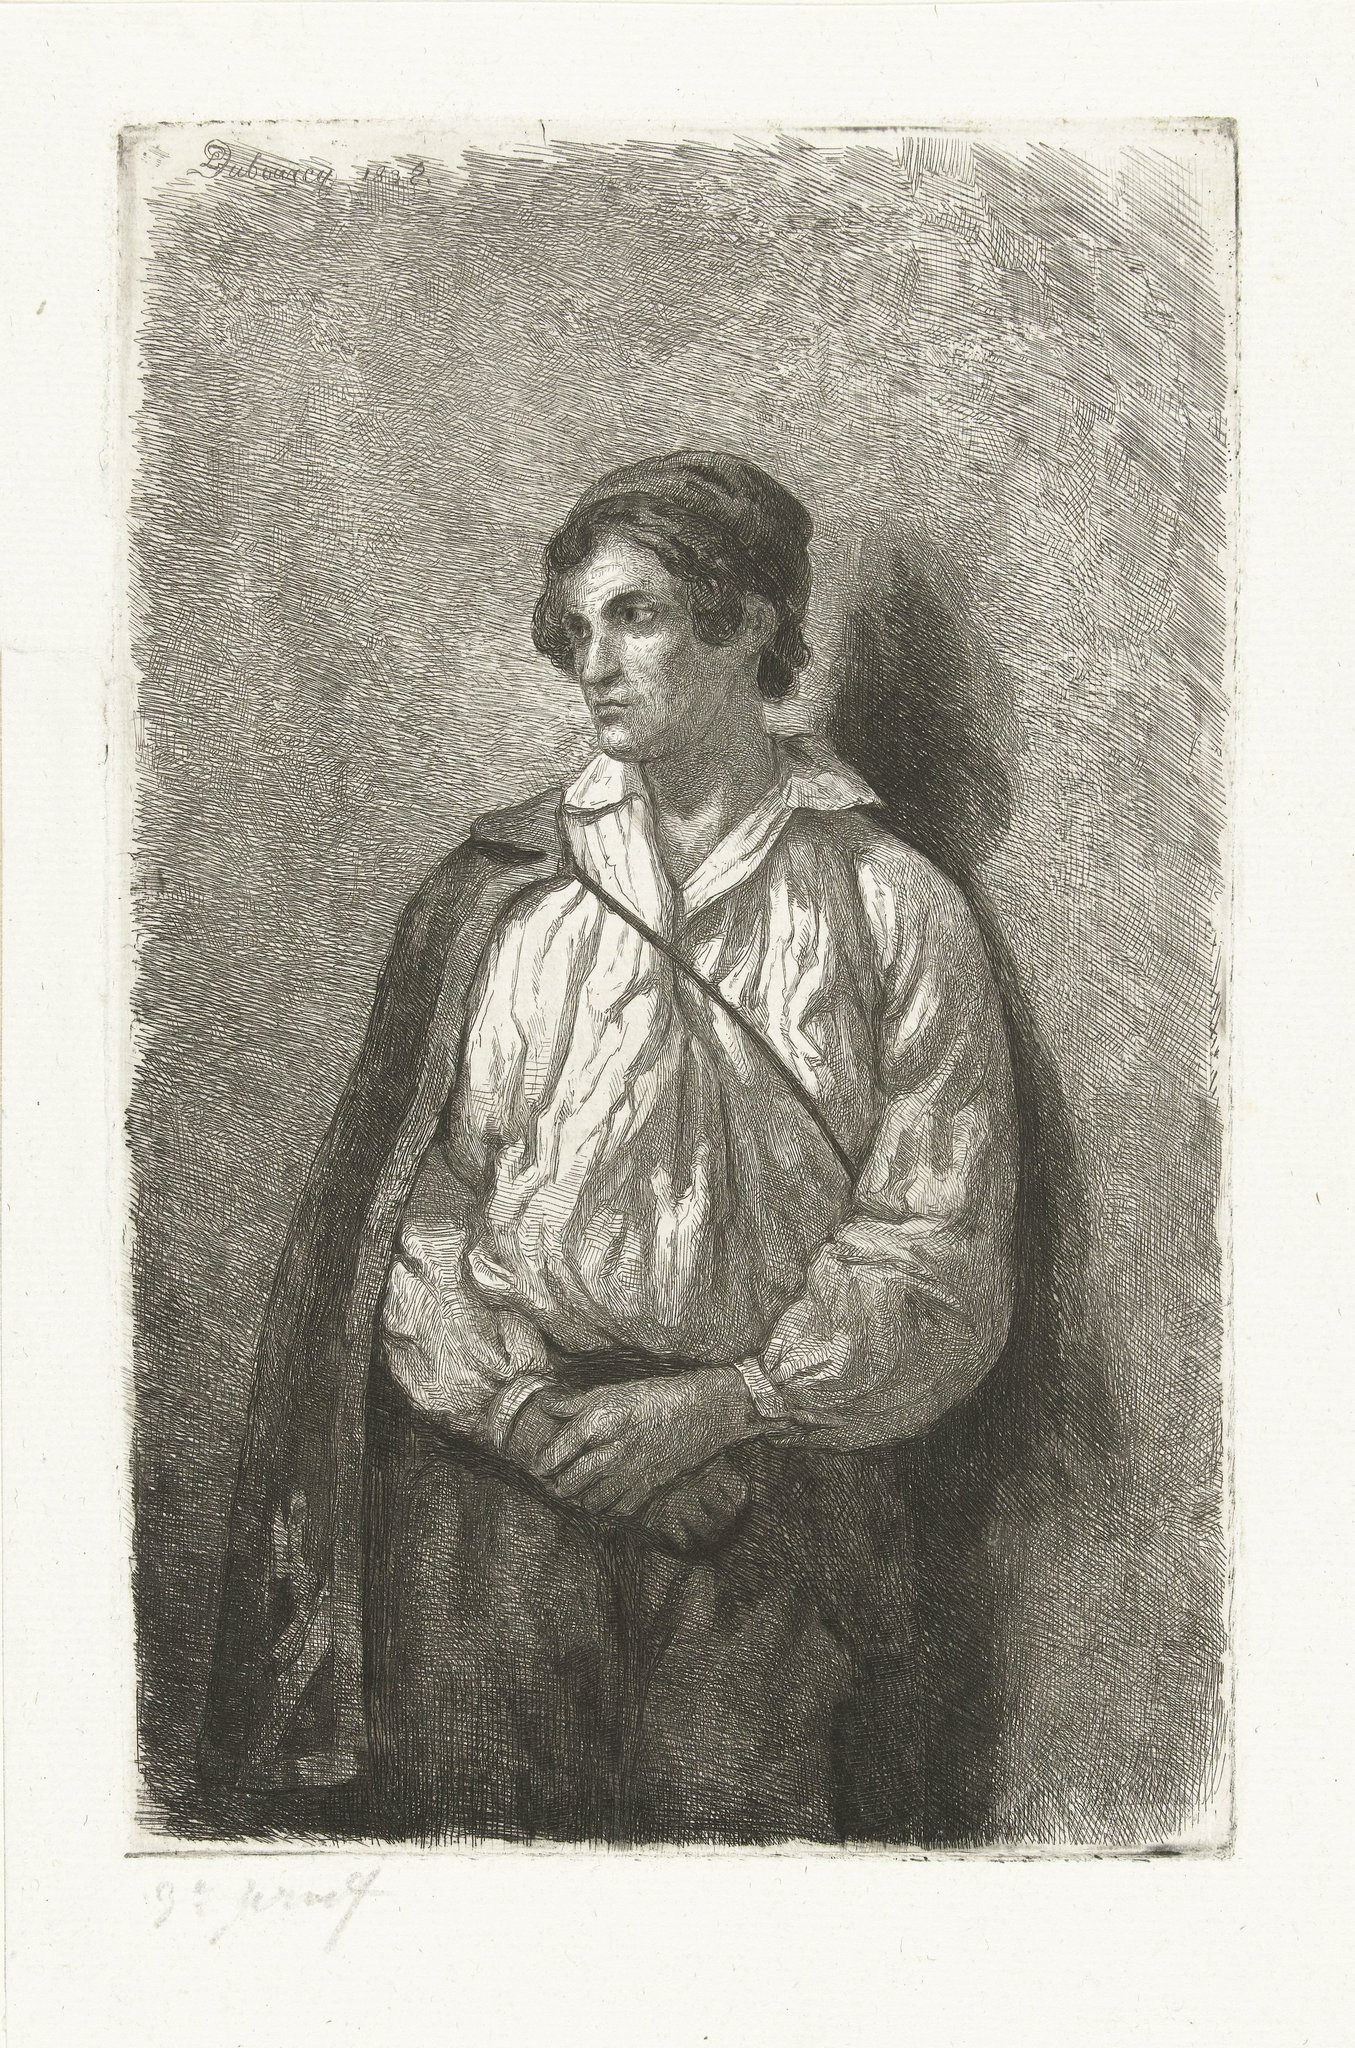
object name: print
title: Portret van een onbekende jonge man met muts en cape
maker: pierre louis dubourcq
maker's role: draughtsman, painter, print maker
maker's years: 1815-1873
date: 1832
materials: paper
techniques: etching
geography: netherlands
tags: anonymous historical person portrayed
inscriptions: collector's mark: Lugt 2228